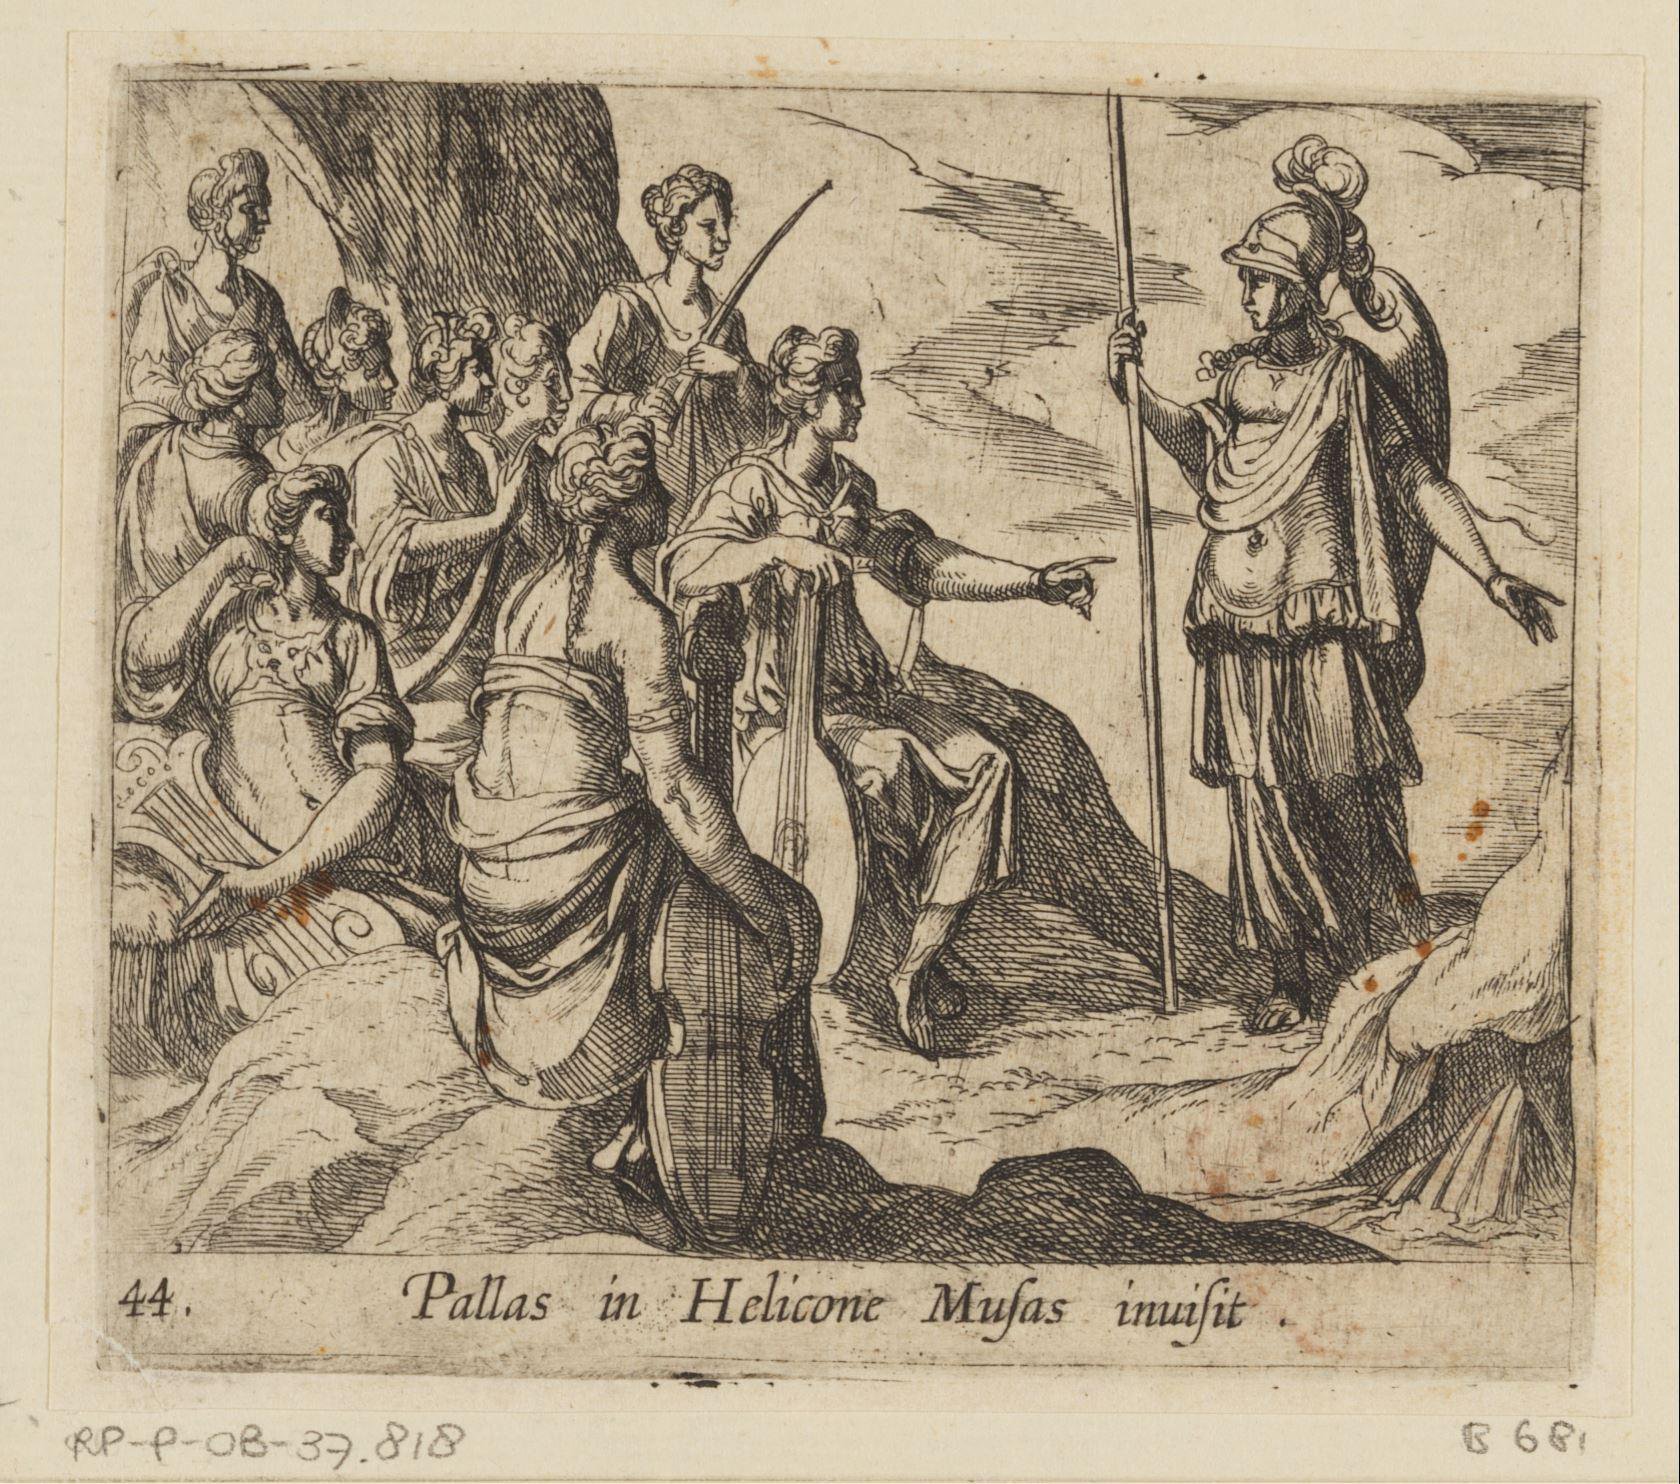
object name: print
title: Pallas in Helicone Musas invisit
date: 1606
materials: paper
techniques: etching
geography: antwerp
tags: minerva visits the muses on mount helicon to see the fountain hippocrene, which pegasus had just brought forth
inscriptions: collector's mark: Lugt 240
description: Deze prent maakt deel uit van een reeks van 150 prenten (+ titelprent) met voorstellingen van de Metamorfosen van Ovidius.